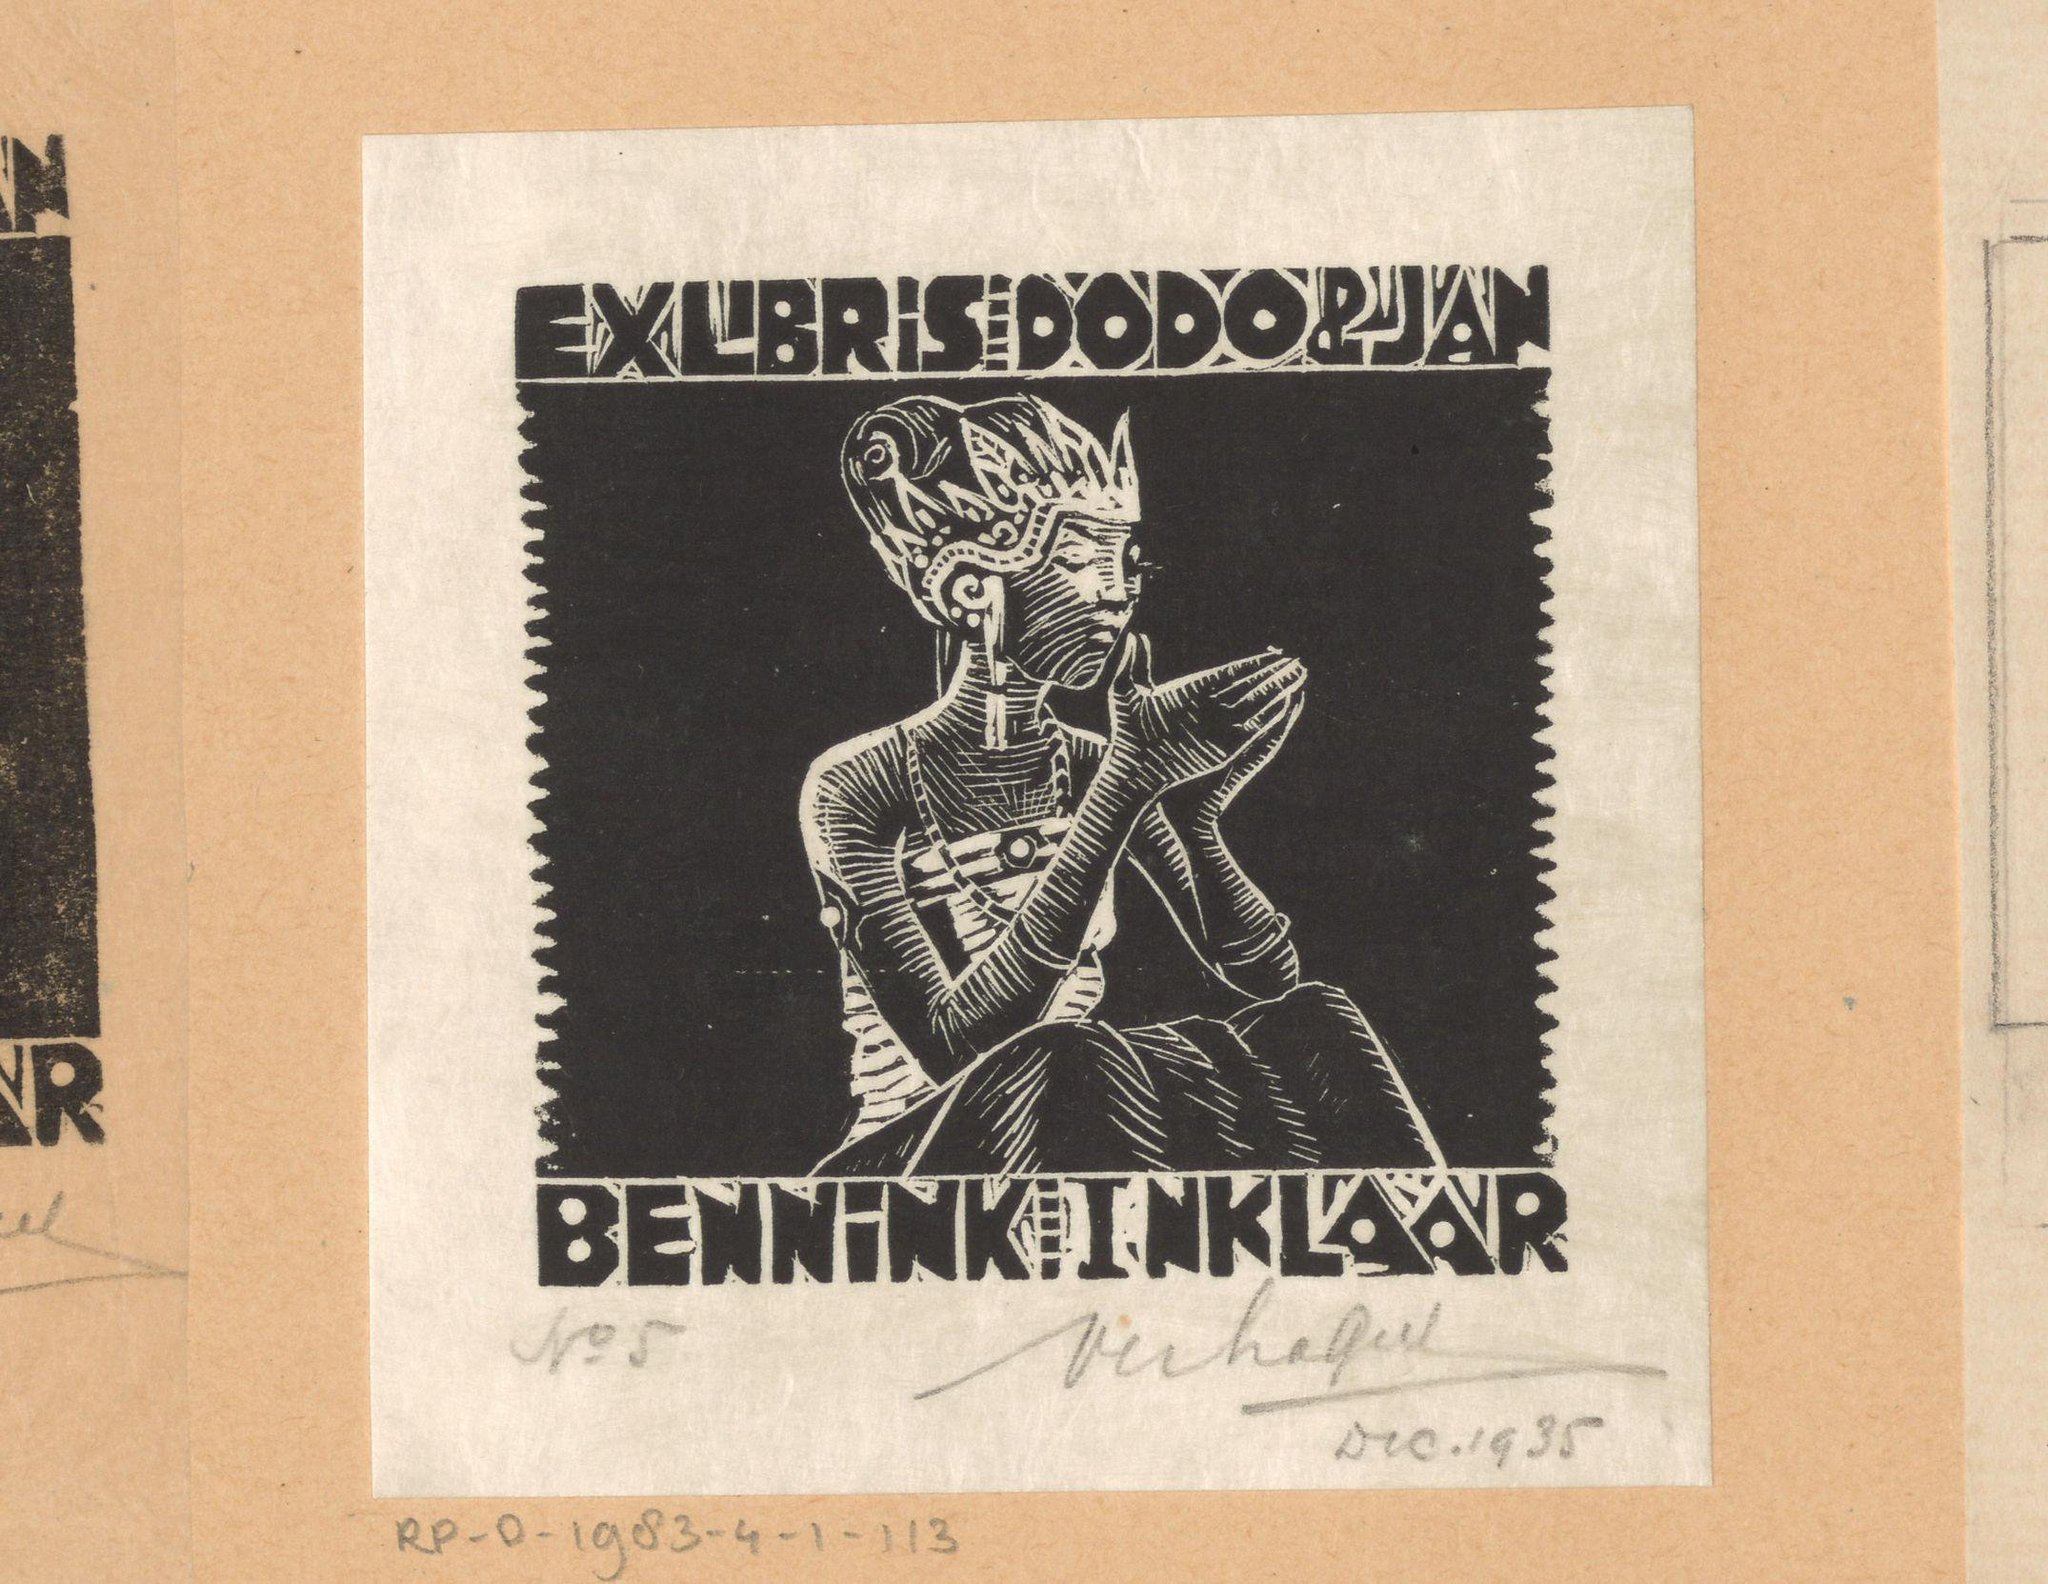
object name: bookplate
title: Ex libris van Dodo en Jan Bennink-Inklaar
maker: otto verhagen (i)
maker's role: draughtsman, print maker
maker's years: 1885-1951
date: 1912-1935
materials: paper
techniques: woodcut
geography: netherlands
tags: adolescent, young woman, maiden, folk costume, regional costume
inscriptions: signature, date and inscription: ‘No. 5/ Verhagen/ Dec. 1935’, inscription: ‘Druk op Jap. papier Super-nacré’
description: Betekenis van de voorstelling is de Oosterse beschaving die een groet (Sembah) aan de Westerse beschaving brengt. Het ex libris is afgebeeld met een druk van het originele blok in "Dutch bookplates" van D. Giltay Veth, New York, 1950.